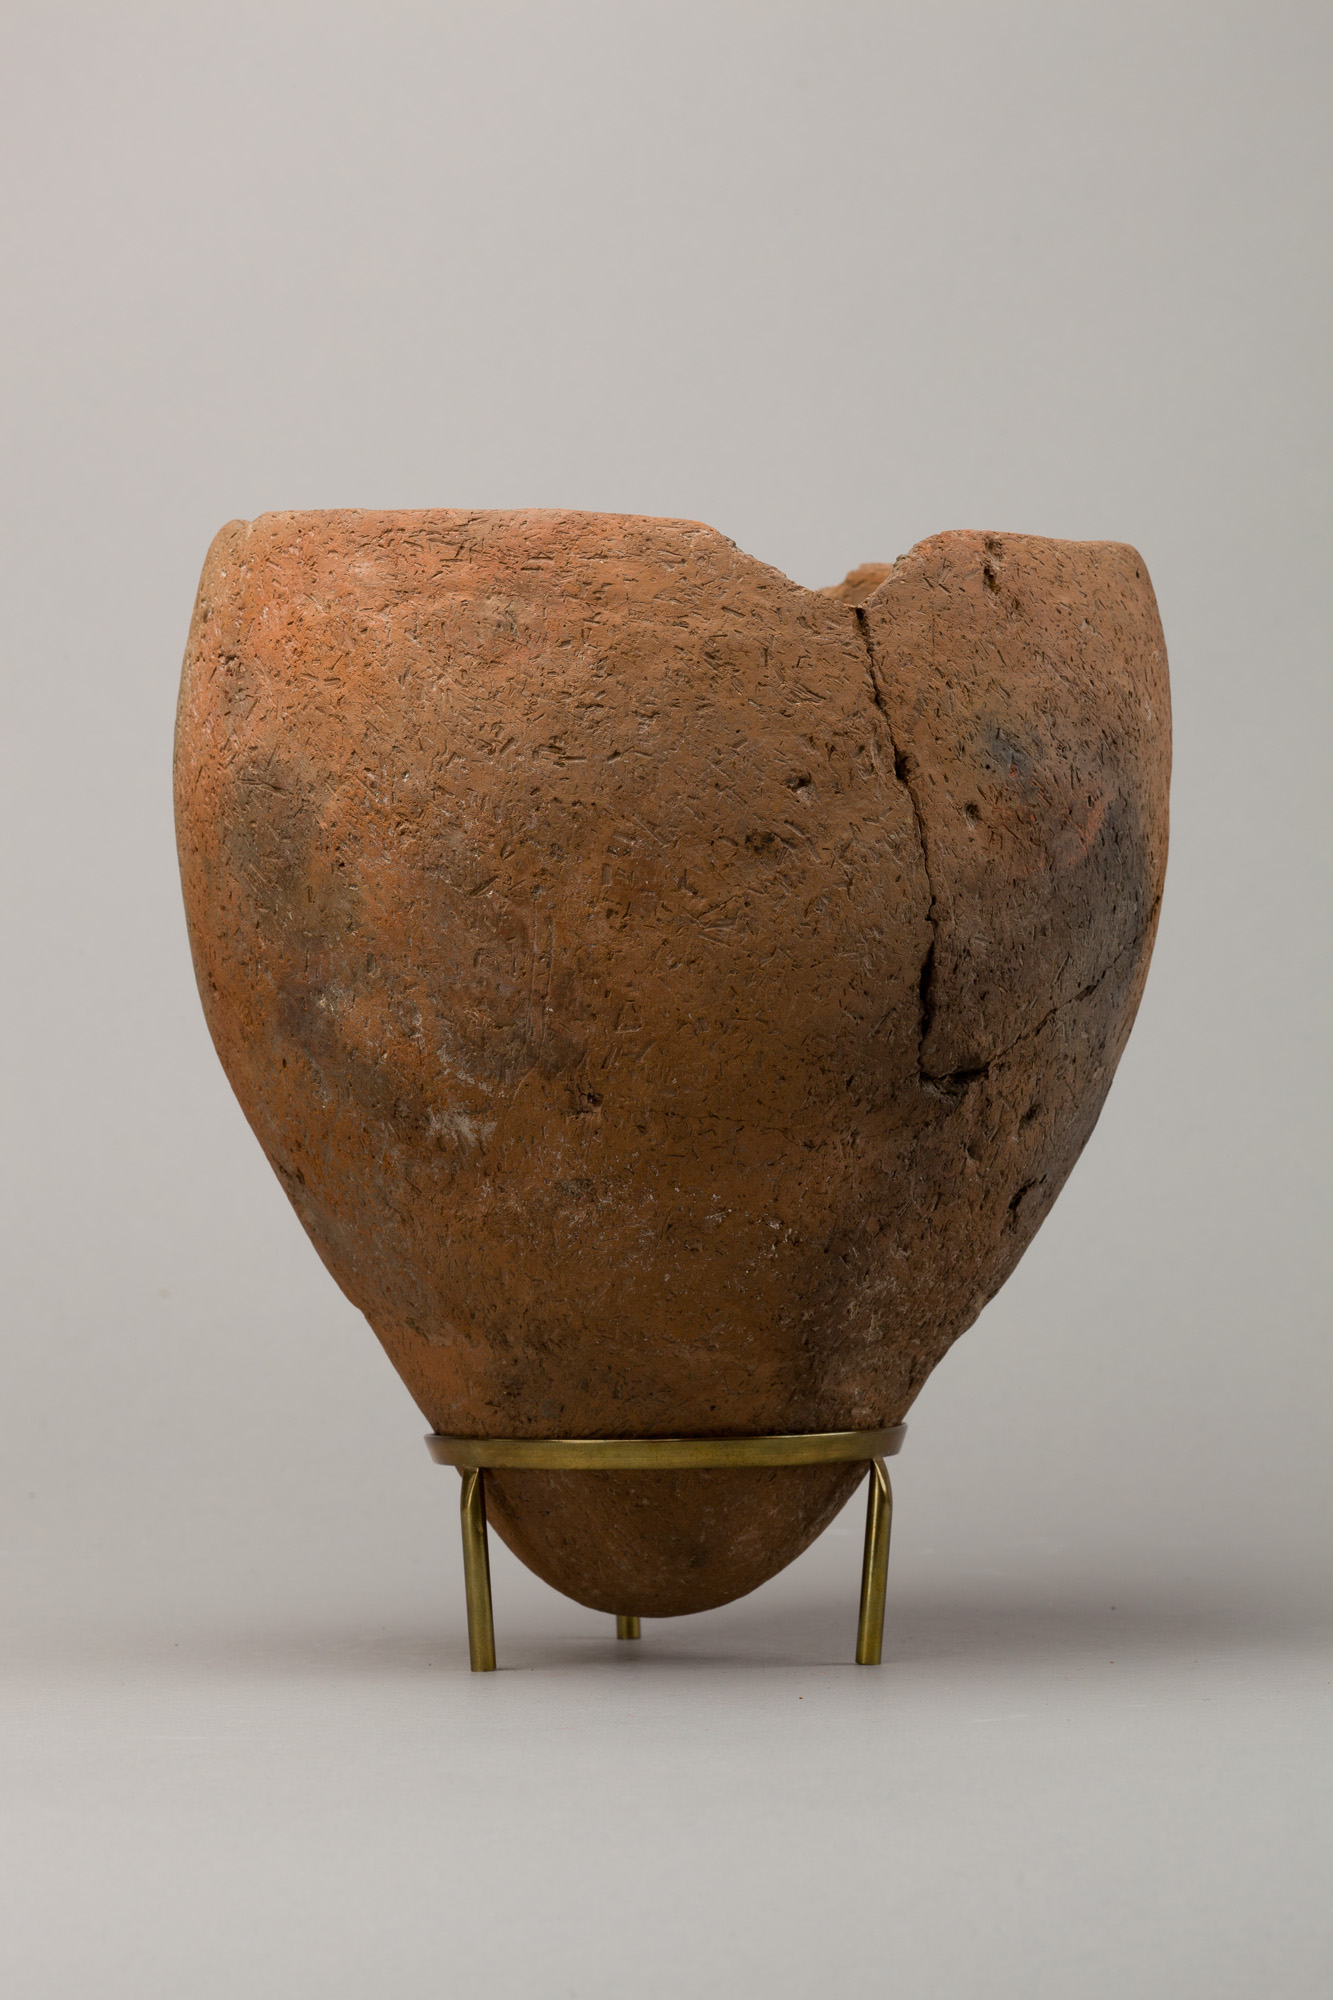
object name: bowl, deep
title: Deep bowl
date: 3850-2960 BCE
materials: pottery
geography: northern upper egypt